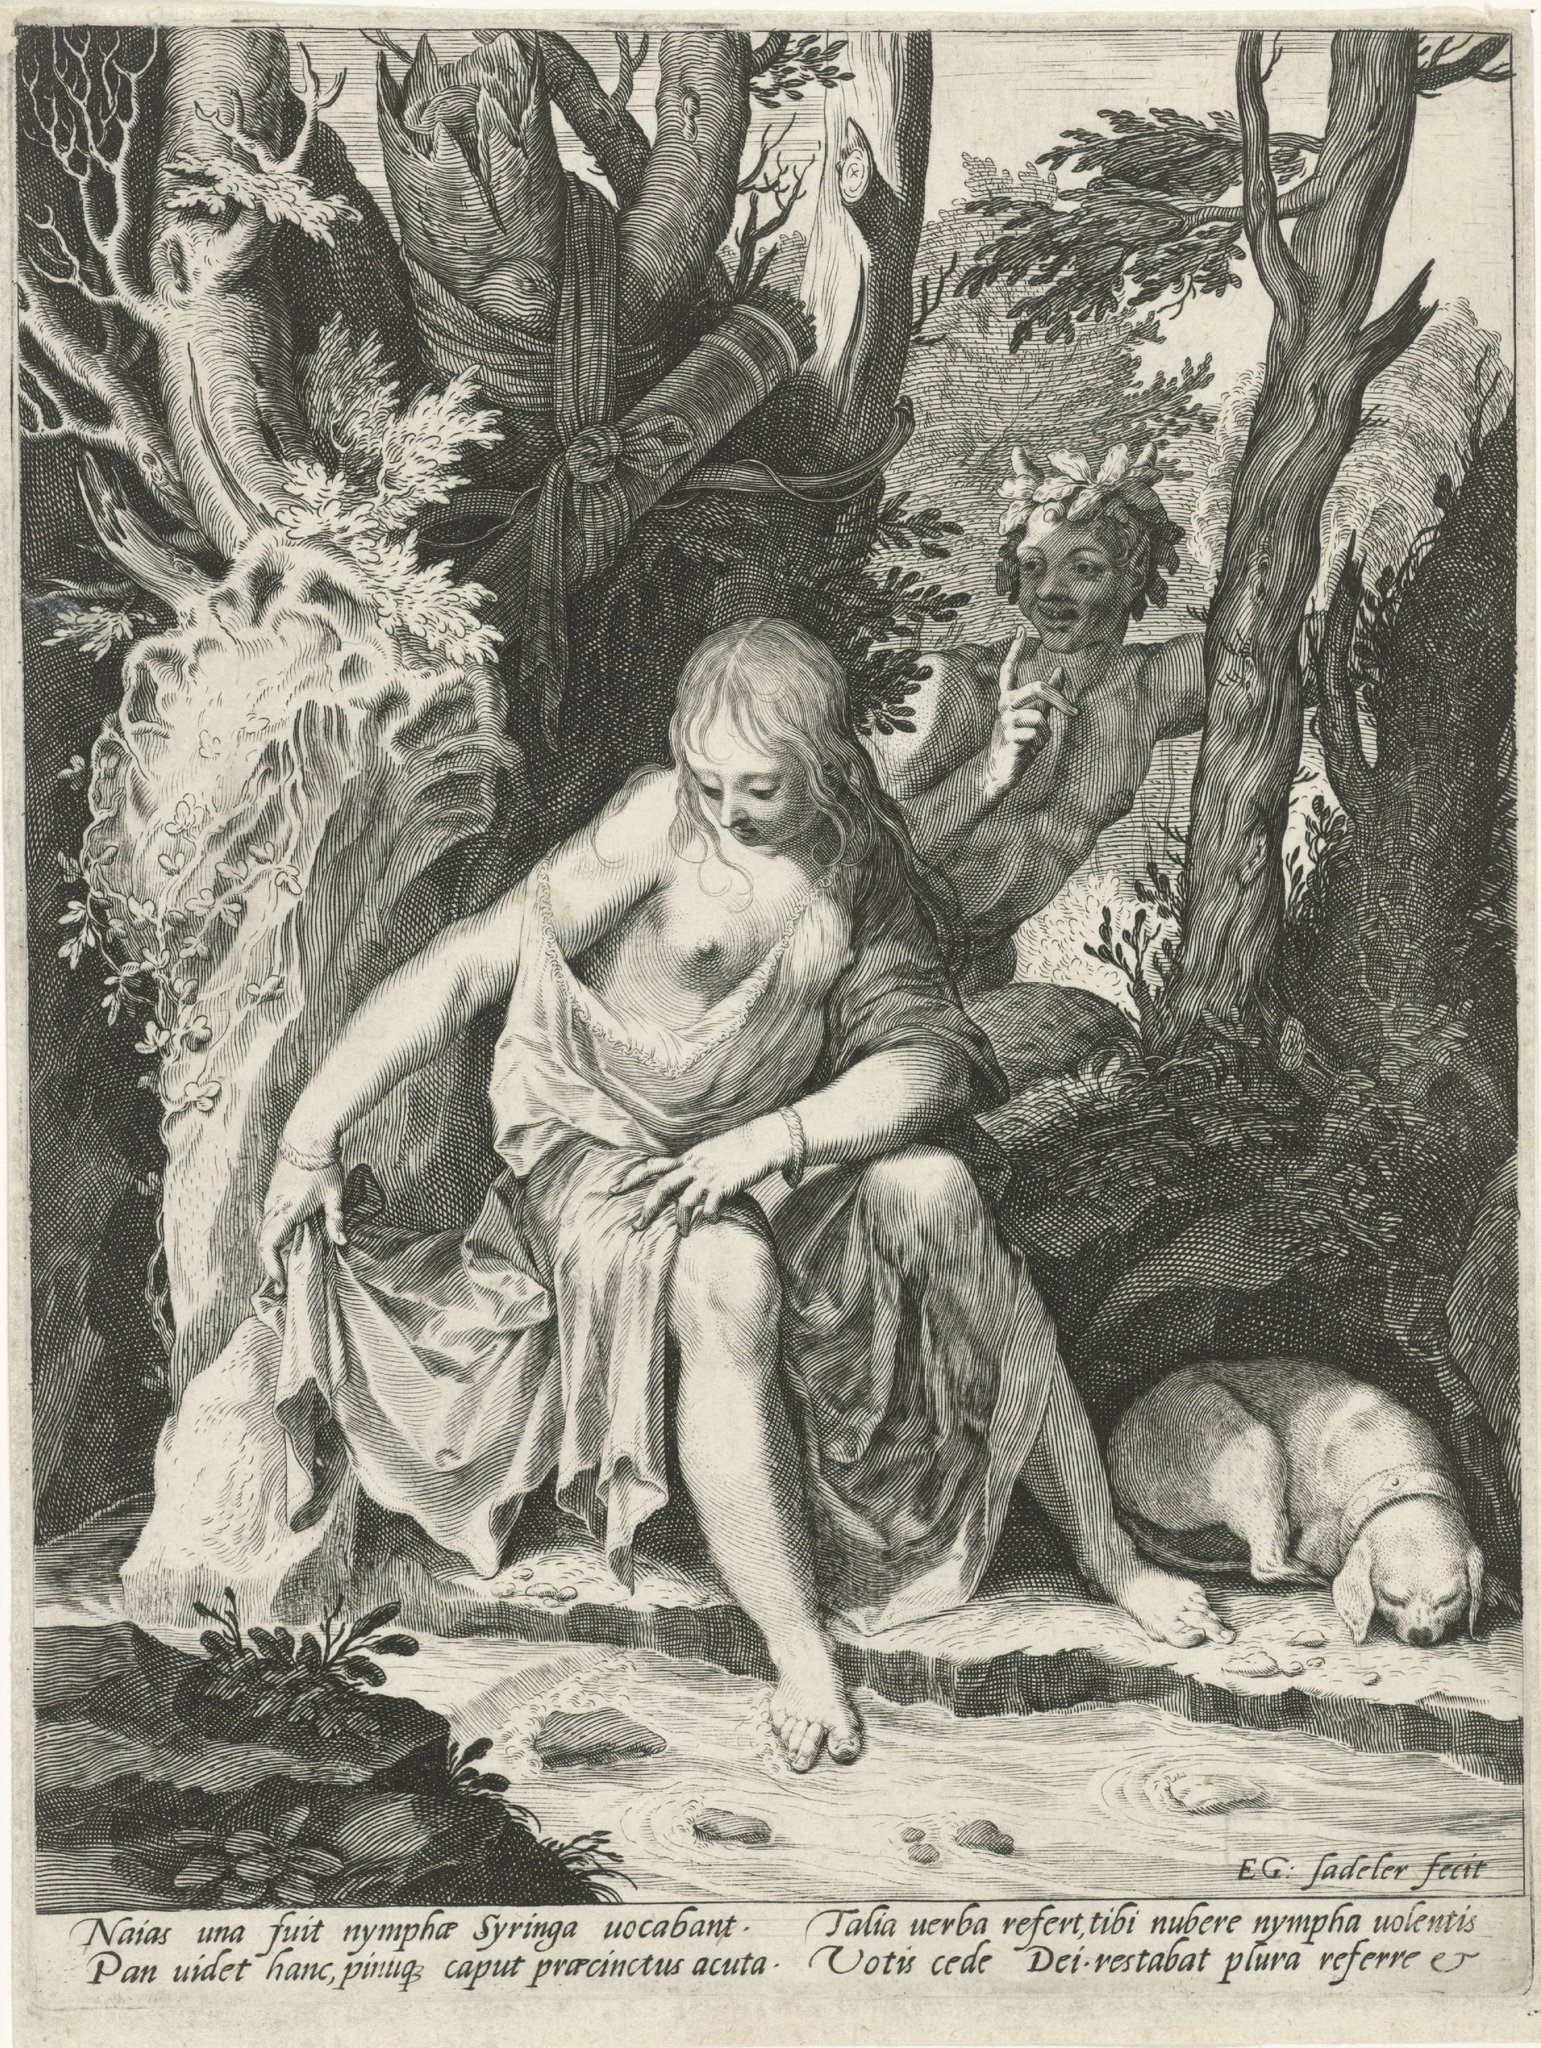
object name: print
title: Pan bespiedt de nimf Syrinx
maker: aegidius sadeler (ii)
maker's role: draughtsman, print maker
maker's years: 1568-1629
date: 1580-1629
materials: paper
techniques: engraving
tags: putting a finger to the lips, 'silentium'; 'silentio' (ripa), single named nymphs (with name), syrinx changed into a reed: while fleeing from pan, the nymph syrinx is changed into reed by her sisters, the naiads (ovid, metamorphoses i 705)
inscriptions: collector's mark: Lugt 240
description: De nimf Syrinx zit, half ontkleed, naast een beekje. Naast haar ligt een hond te slapen. Achter haar, tussen de bomen, gluurt Pan naar haar en maakt een 'stilte' gebaar met de vinger voor de mond. De prent heeft een Latijns onderschrift.